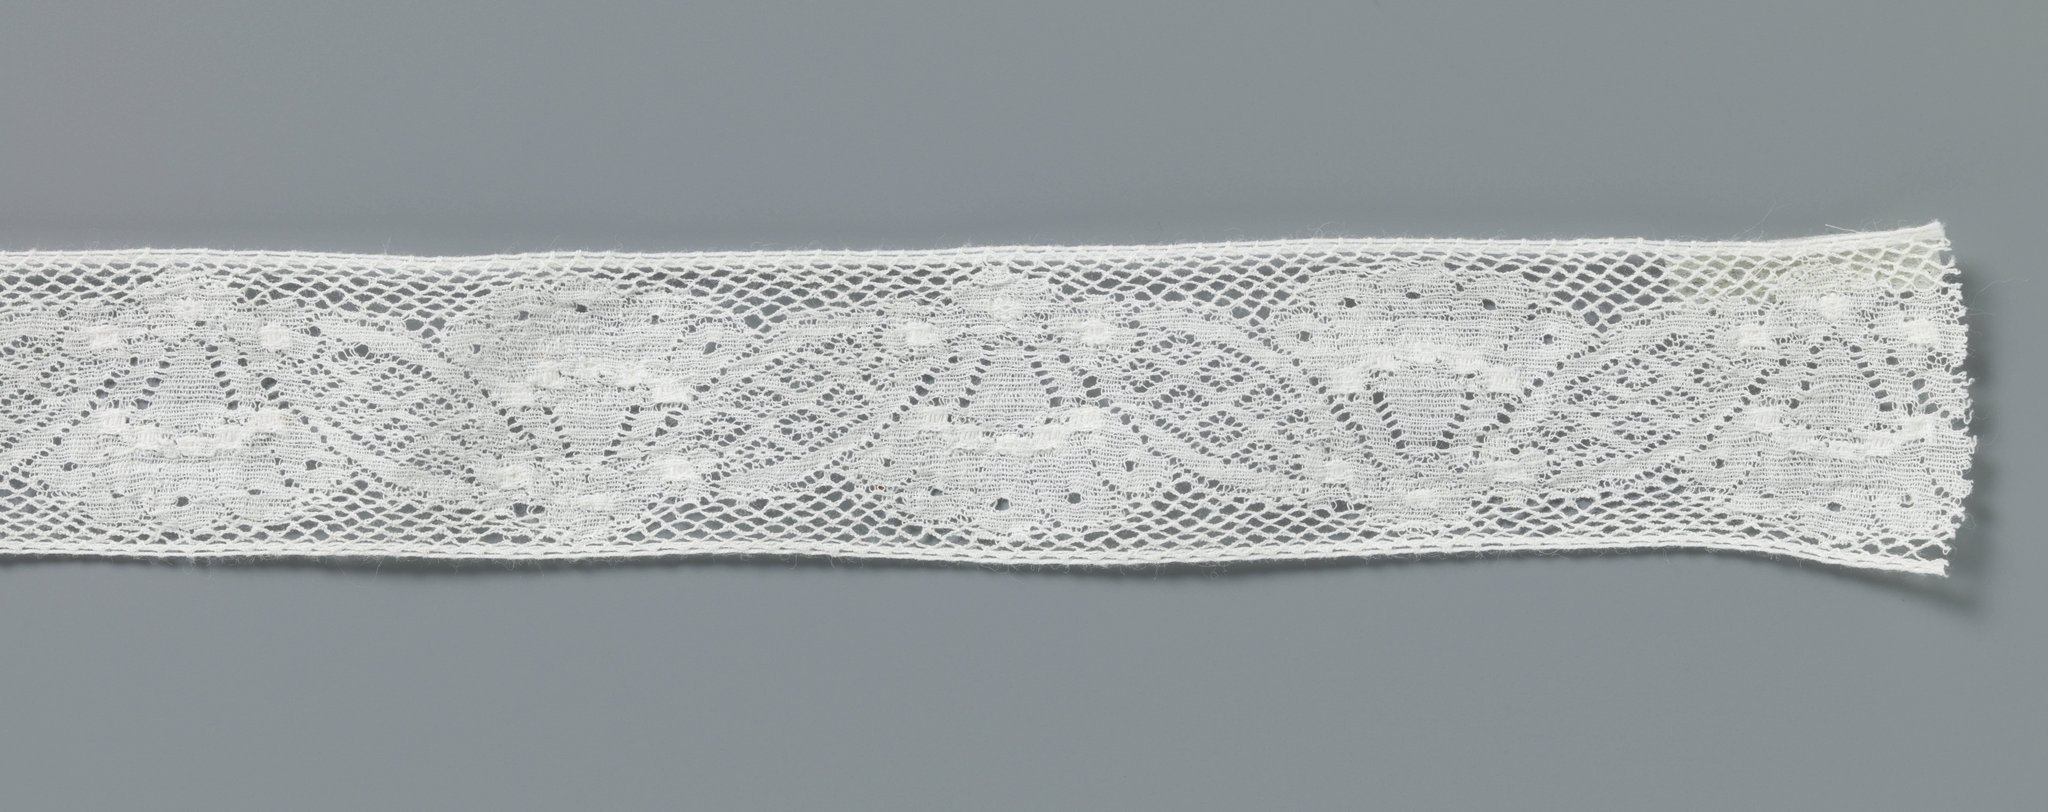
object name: strip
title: Tussenzetsel van machinale kant met kelkbloem tussen twee spitsovale bladeren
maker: Anonymous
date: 1900-1915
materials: cotton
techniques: lace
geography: europe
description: Tussenzetsel van naturelkleurige machinale kant. Het zich herhalende en aaneengeschakelde patroon bestaat uit een kelkbloem tussen twee spitsovale bladeren. De bloem heeft vijf lobjes aan de bovenkant en is afwisselend omhoog of omlaag gericht, waarbij de bladeren met elkaar gedeeld worden. De motieven lijken te zijn gemaakt in linnenslag met opengewerkte randjes en met enkele uitsparingen. In de bloem is een rijtje met blokvormige verdikkingen ter versiering aangebracht. De motieven zijn met elkaar verbonden door een machinale vierkante Valenciennes-grond. In de bladeren is een ruitvormig raster een machinale sneeuwvlokkengrond als siergrond toegepast. Boven- en onderzijde van de strook zijn recht afgewerkt.